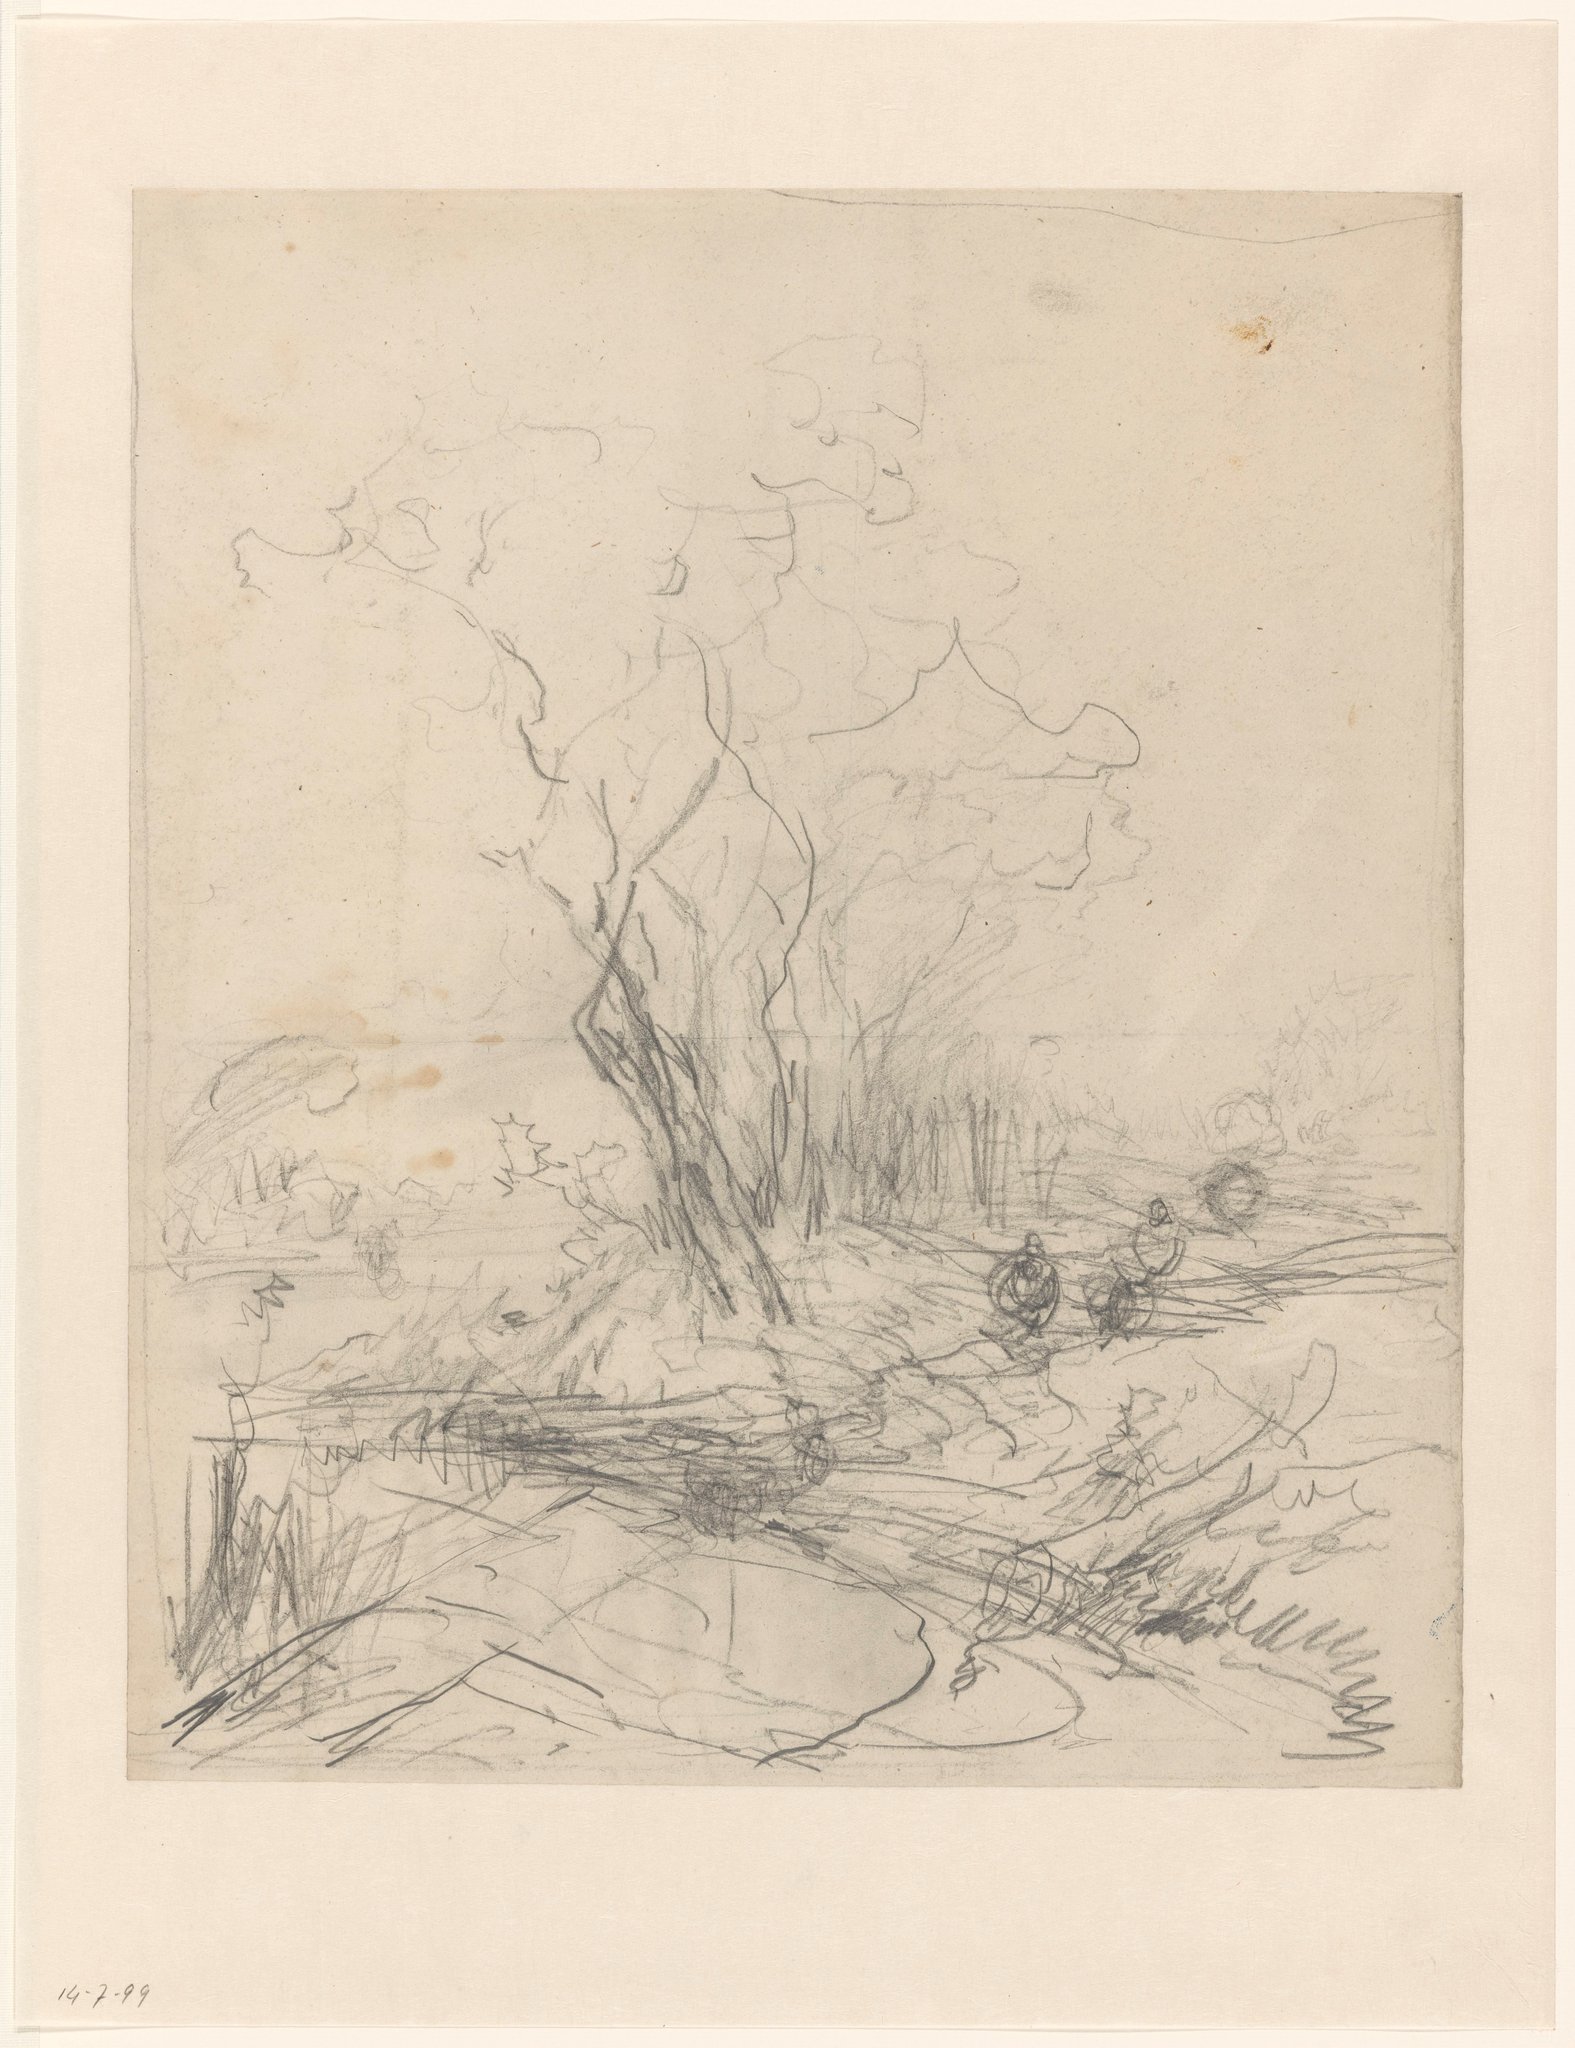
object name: drawing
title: Schets van bomen aan een weg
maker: andreas schelfhout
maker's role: draughtsman, painter, print maker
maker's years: 1787-1870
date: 1797-1870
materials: paper, pencil